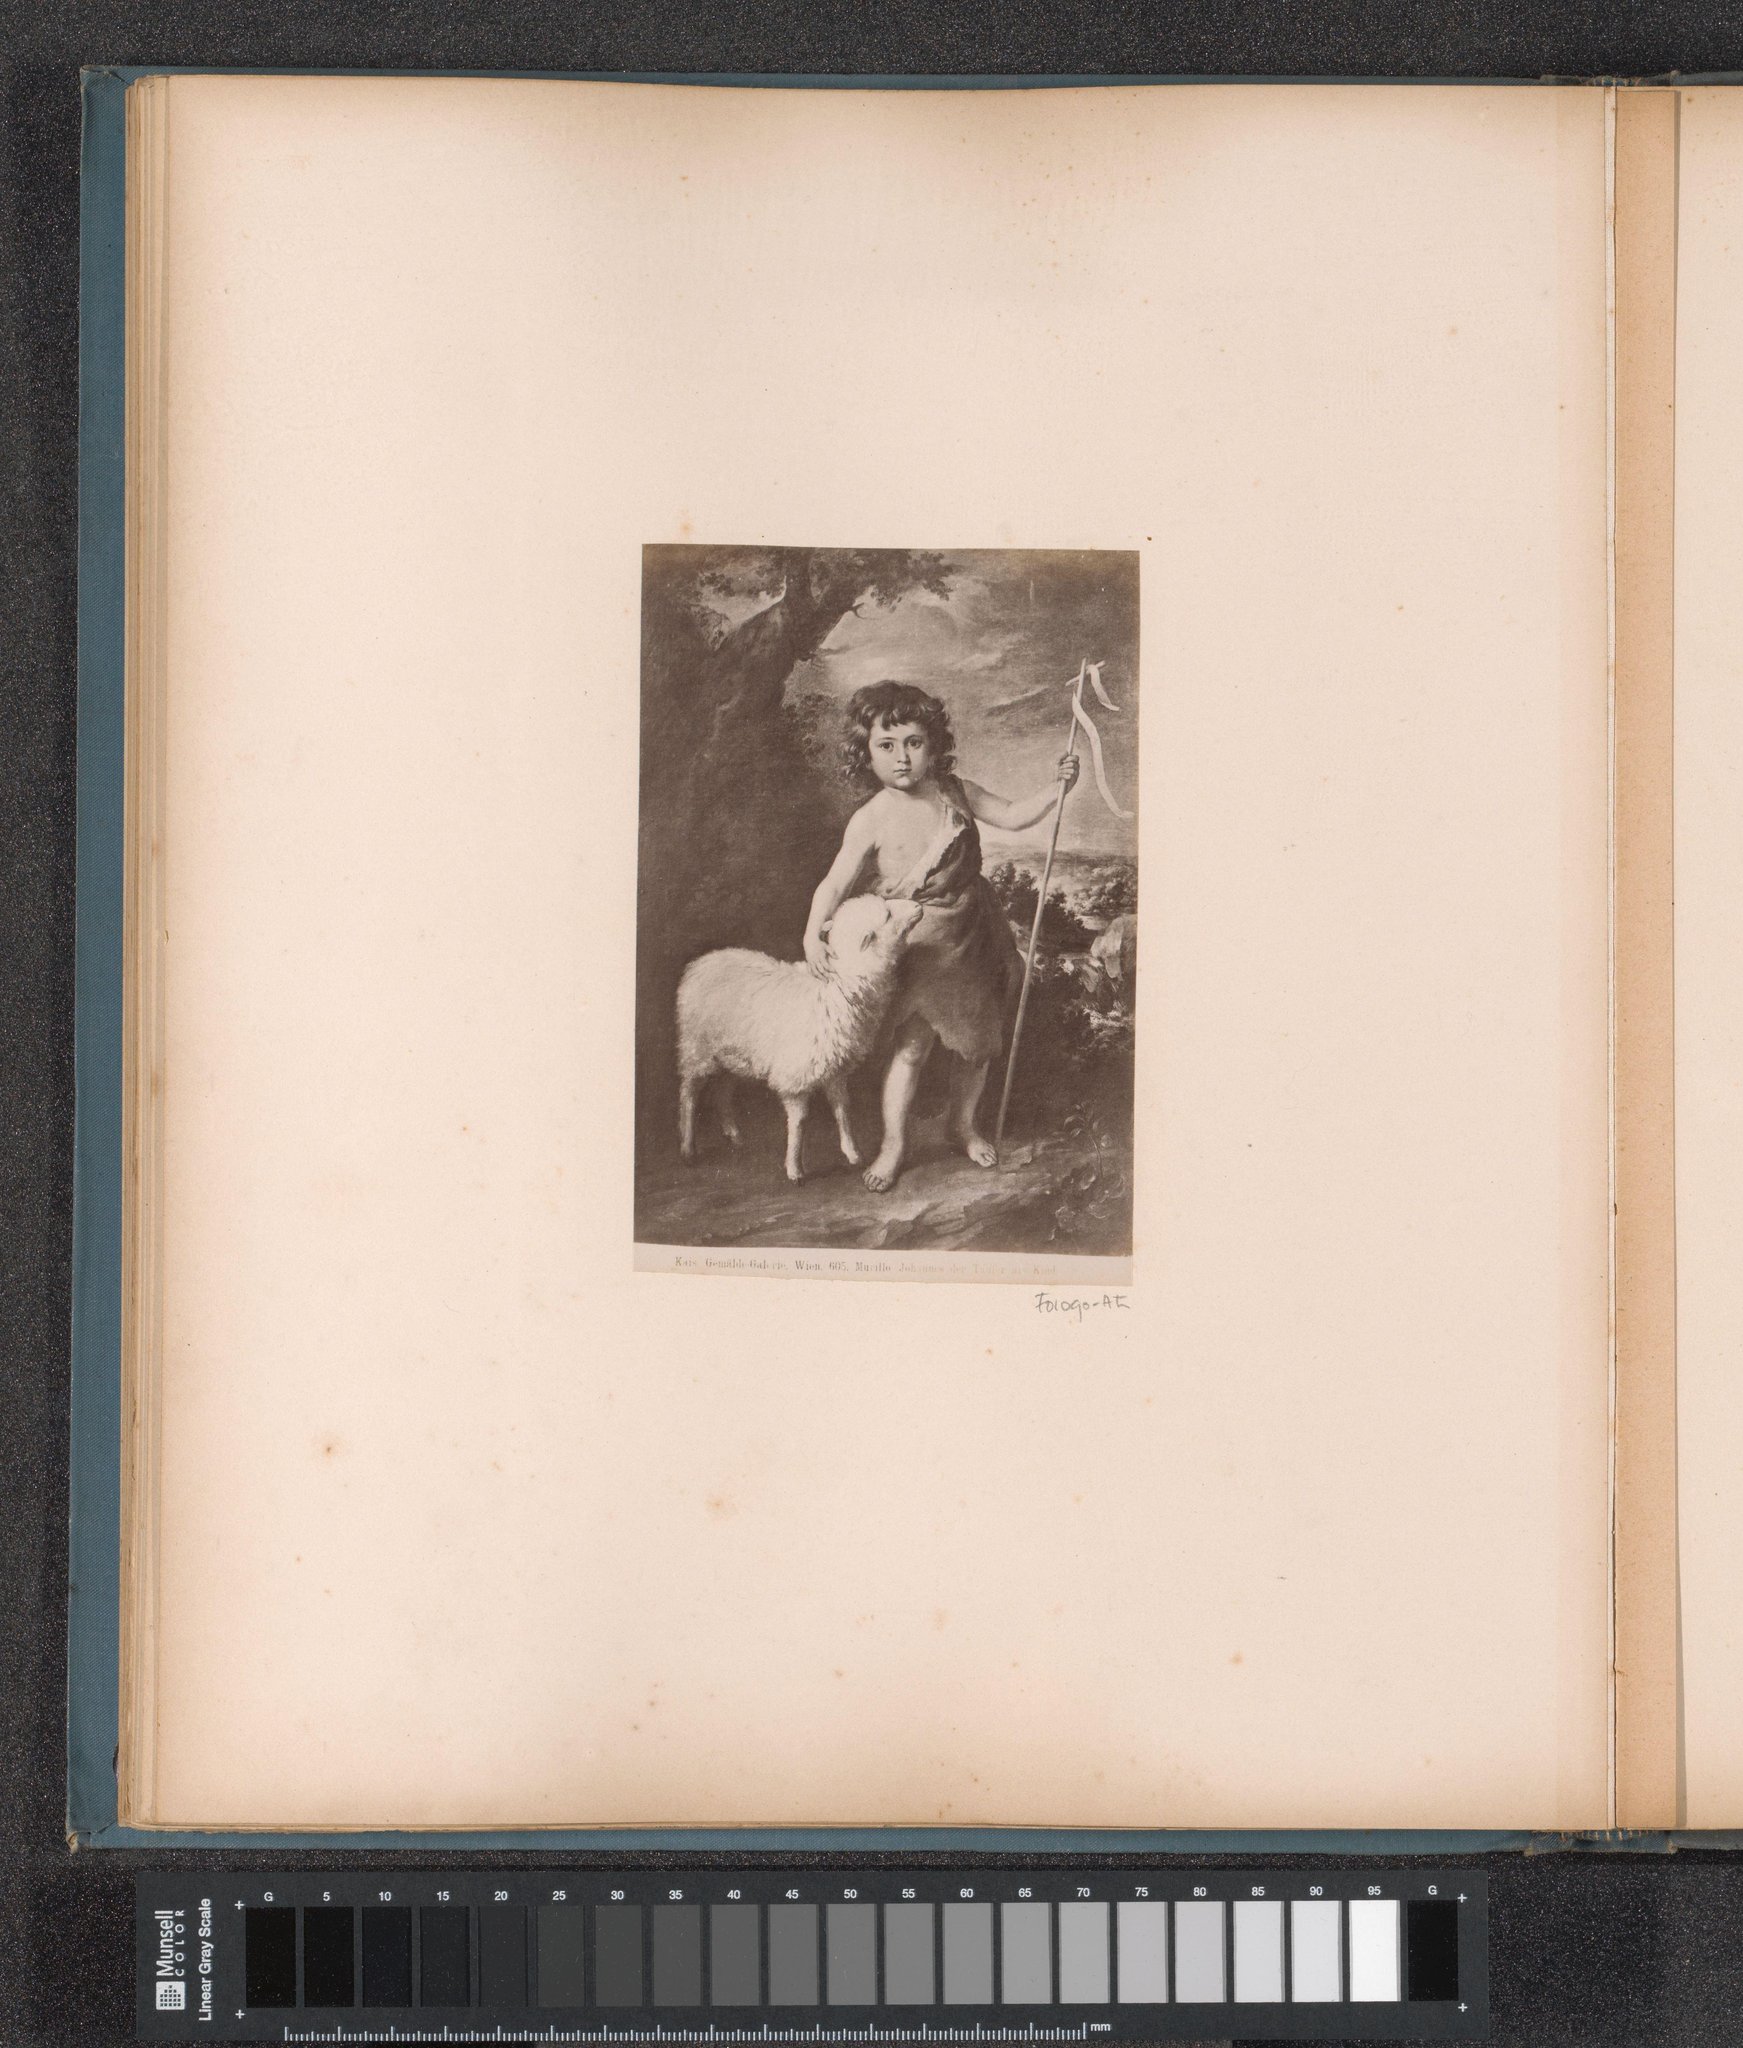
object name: photograph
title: Kais. Gemäldegalerie. Wien. Murillo Johannes der Taufer als Kind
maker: Anonymous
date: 1870-1900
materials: paper, photographic support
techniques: albumen print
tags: john the baptist; possible attributes: book, reed cross, baptismal cup, honeycomb, lamb, staff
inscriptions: check stamp: ‘[...]’, negative number: ‘605’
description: Onderdeel van Reisalbum met foto's van bezienswaardigheden in Duitsland en Oostenrijk en van kunstwerken.